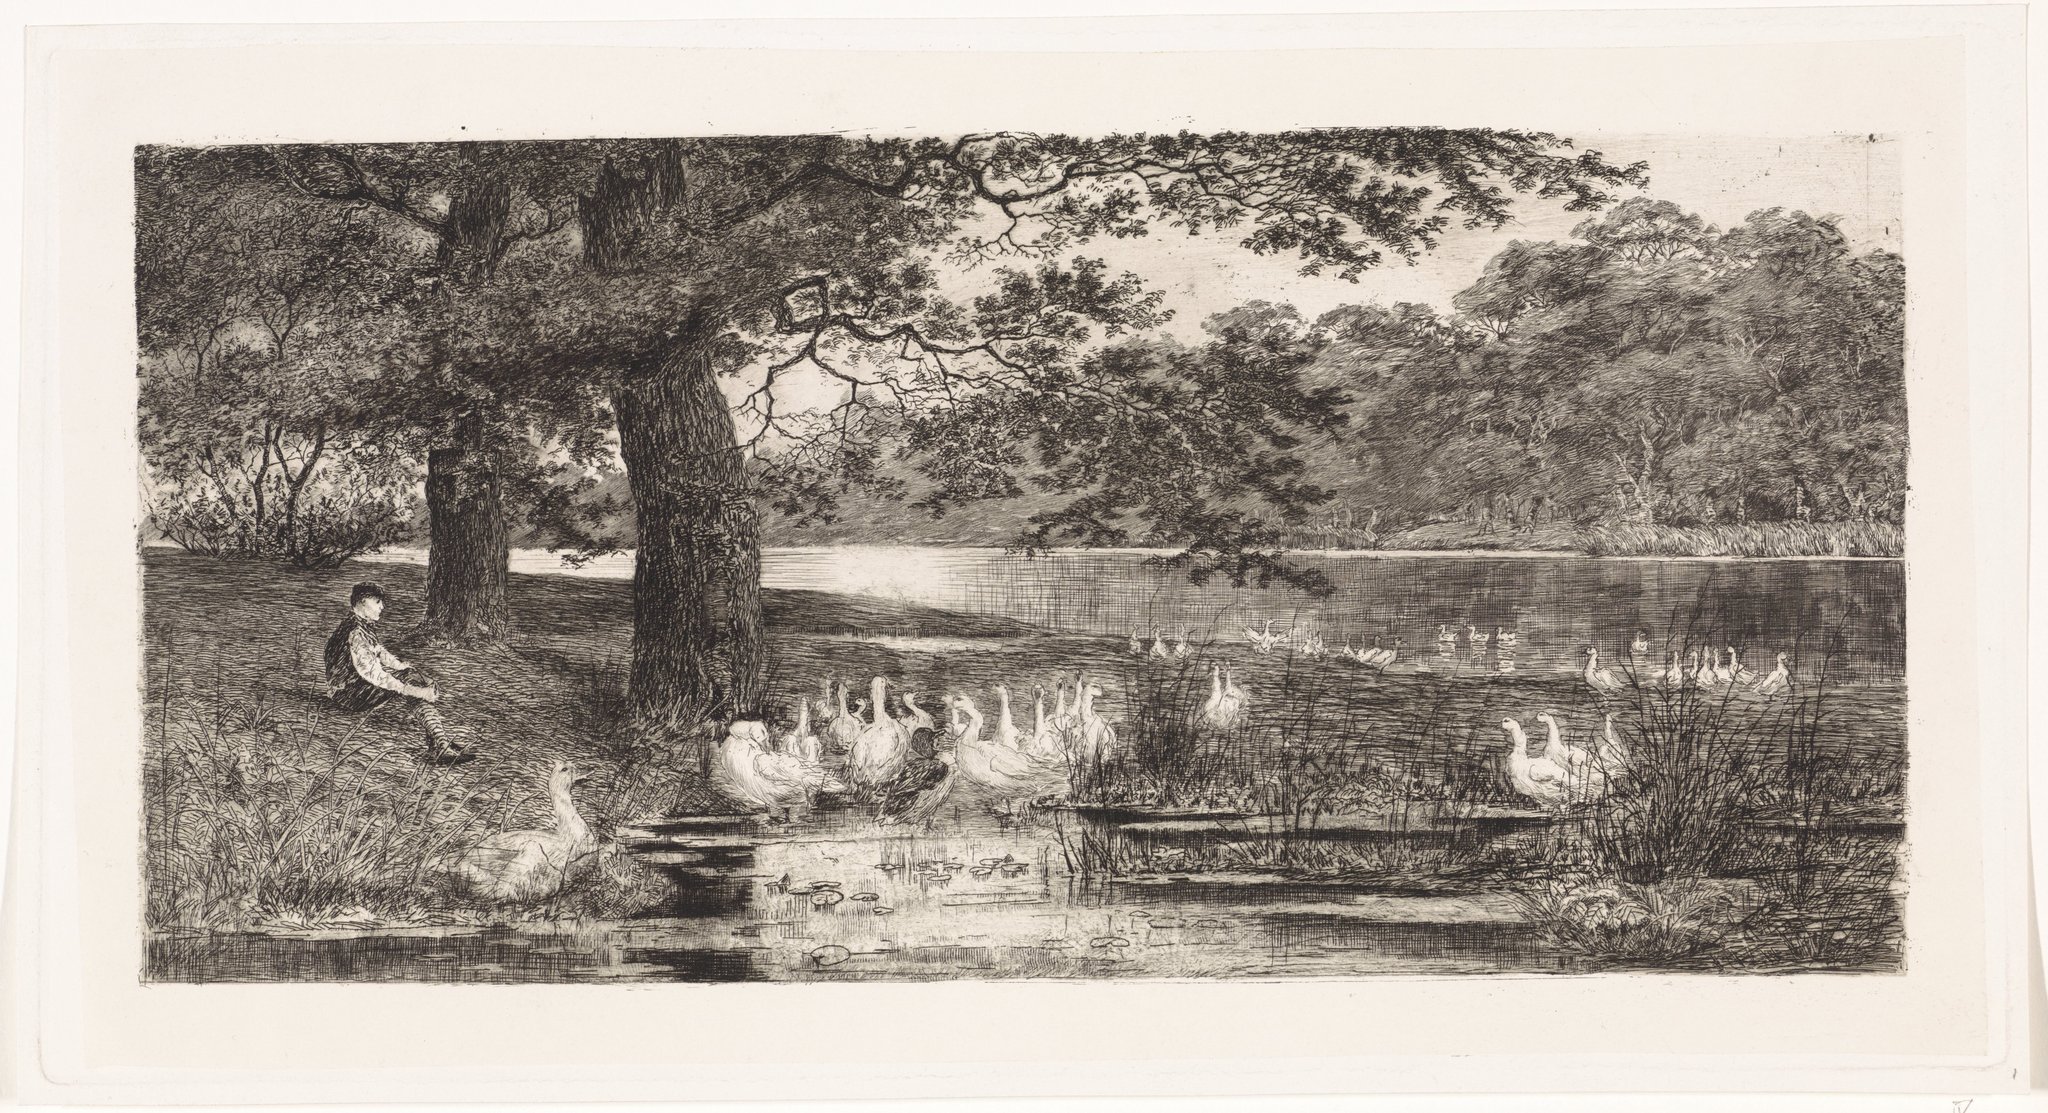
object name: print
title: Ganzen bij het water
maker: elias stark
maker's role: draughtsman, print maker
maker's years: 1849-1933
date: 1887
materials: paper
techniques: etching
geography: nieuwer-amstel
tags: trees, water-birds: goose, youth, adolescent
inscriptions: collector's mark: Lugt 2228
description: Een troep ganzen aan het water. Op de oever onder de bomen zit een jongen met zijn armen om zijn knieën geslagen.